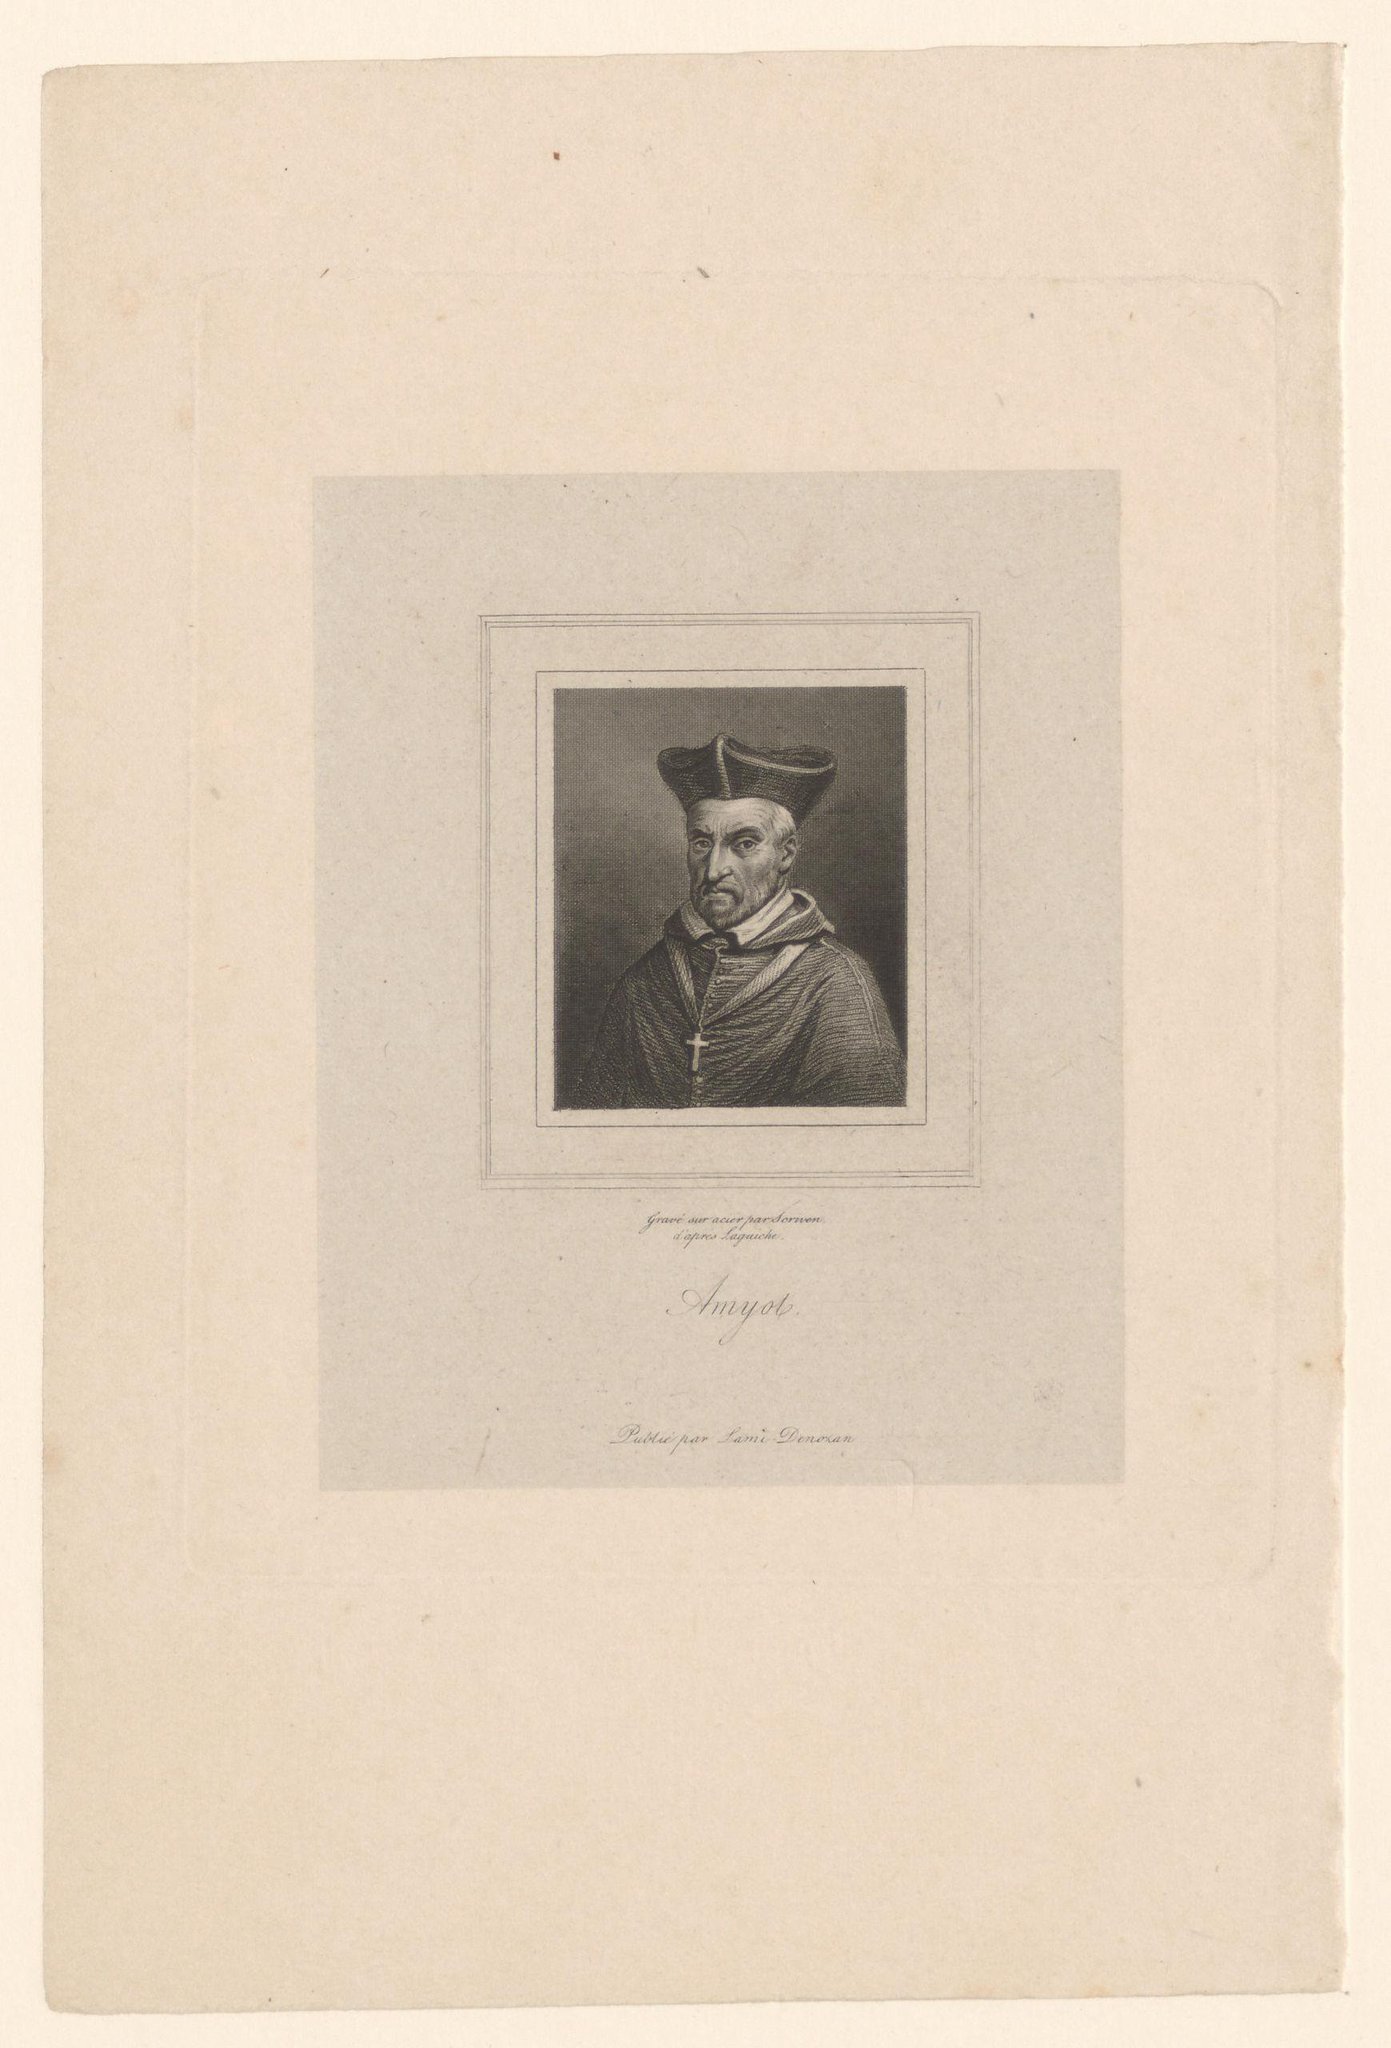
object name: print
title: Portret van Jacques Amyot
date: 1826-1841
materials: paper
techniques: etching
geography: paris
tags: historical persons, portrait of a writer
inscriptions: collector's mark: Lugt 2228